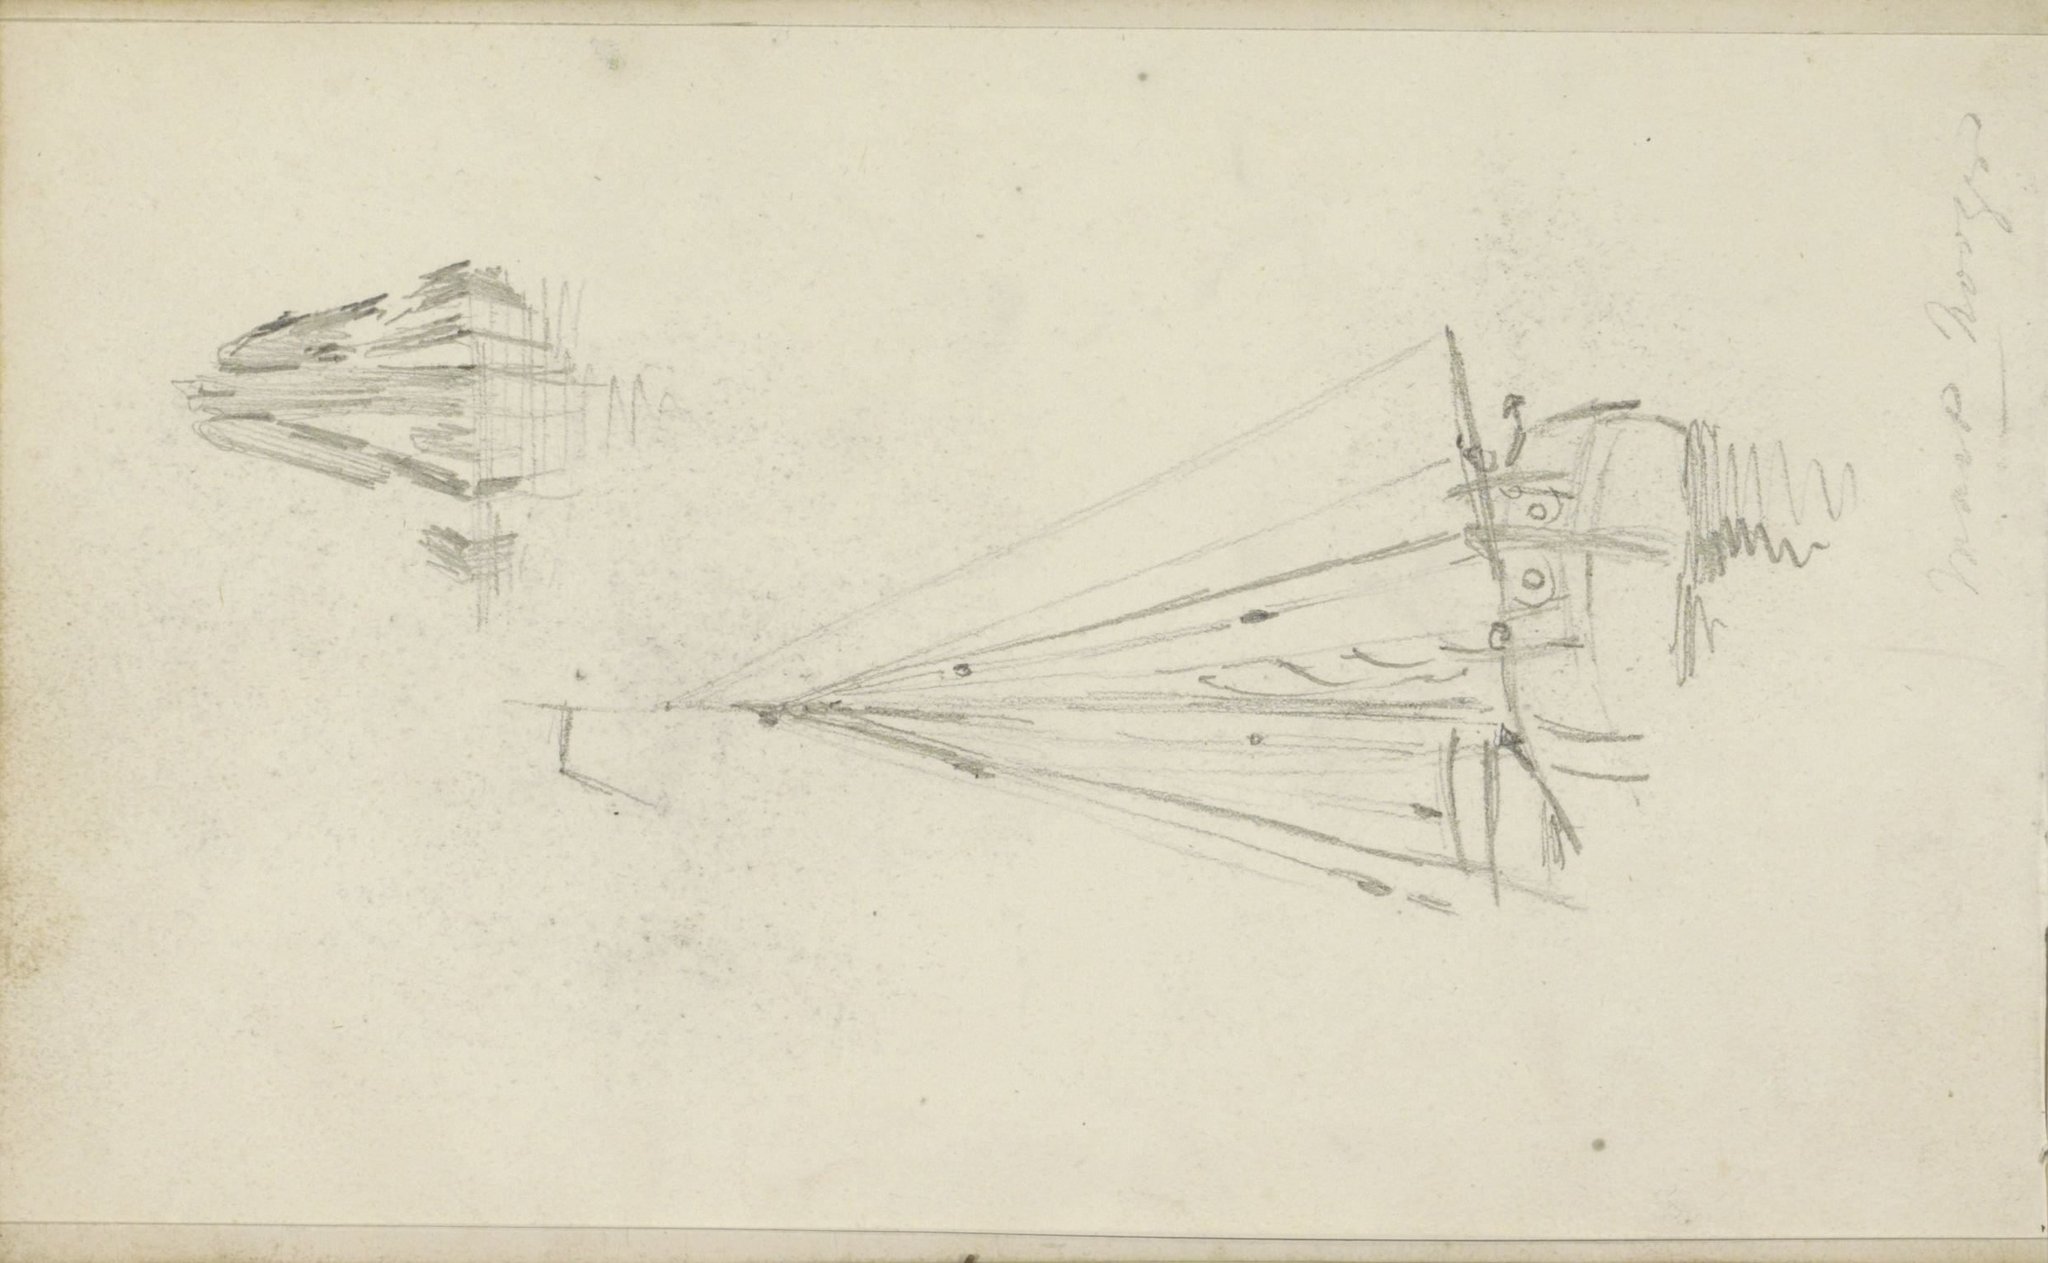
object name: sketchbook leaf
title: Zeilschip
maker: adrianus eversen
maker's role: draughtsman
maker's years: 1818-1897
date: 1828-1897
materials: paper, pencil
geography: netherlands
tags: sailing-ship, sailing-boat, parts of ship's exterior: bow, mooring-buoy, bollard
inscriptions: annotation: ‘[...]’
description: Zeilschip, van voren gezien. De boegspriet steekt uit en in de mast hangt een vlag. Rechtsboven een meerpaal. Blad 1 verso uit een schetsboek met 27 bladen.